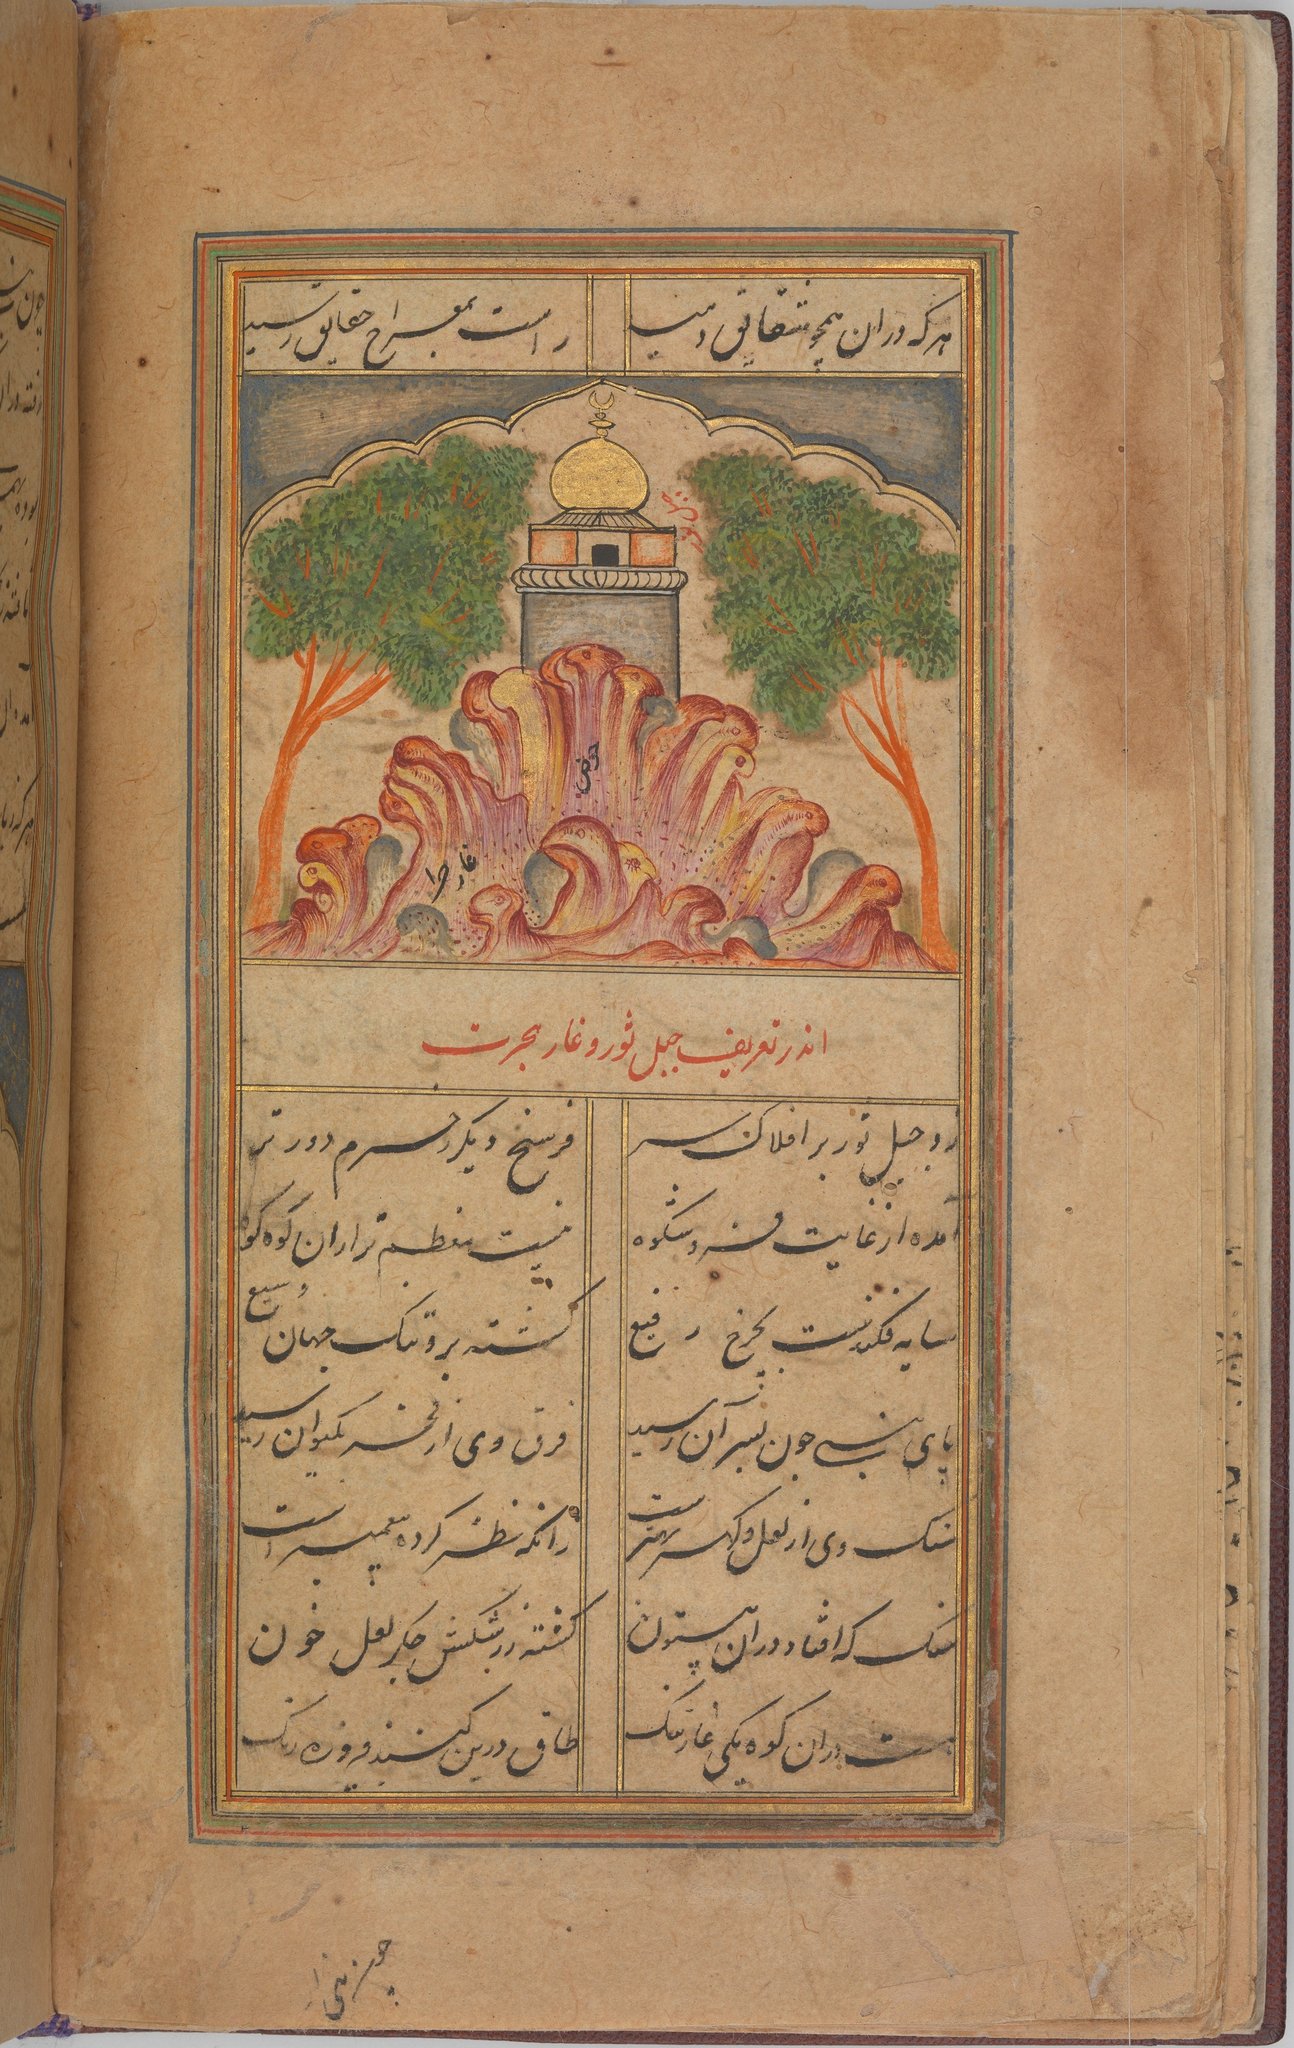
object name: illustrated manuscript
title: Futuh al-Haramayn (Description of the Holy Cities)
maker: muhi al-din lari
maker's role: author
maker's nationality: iranian or indian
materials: gold, ink, paper, watercolor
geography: india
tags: calligraphy